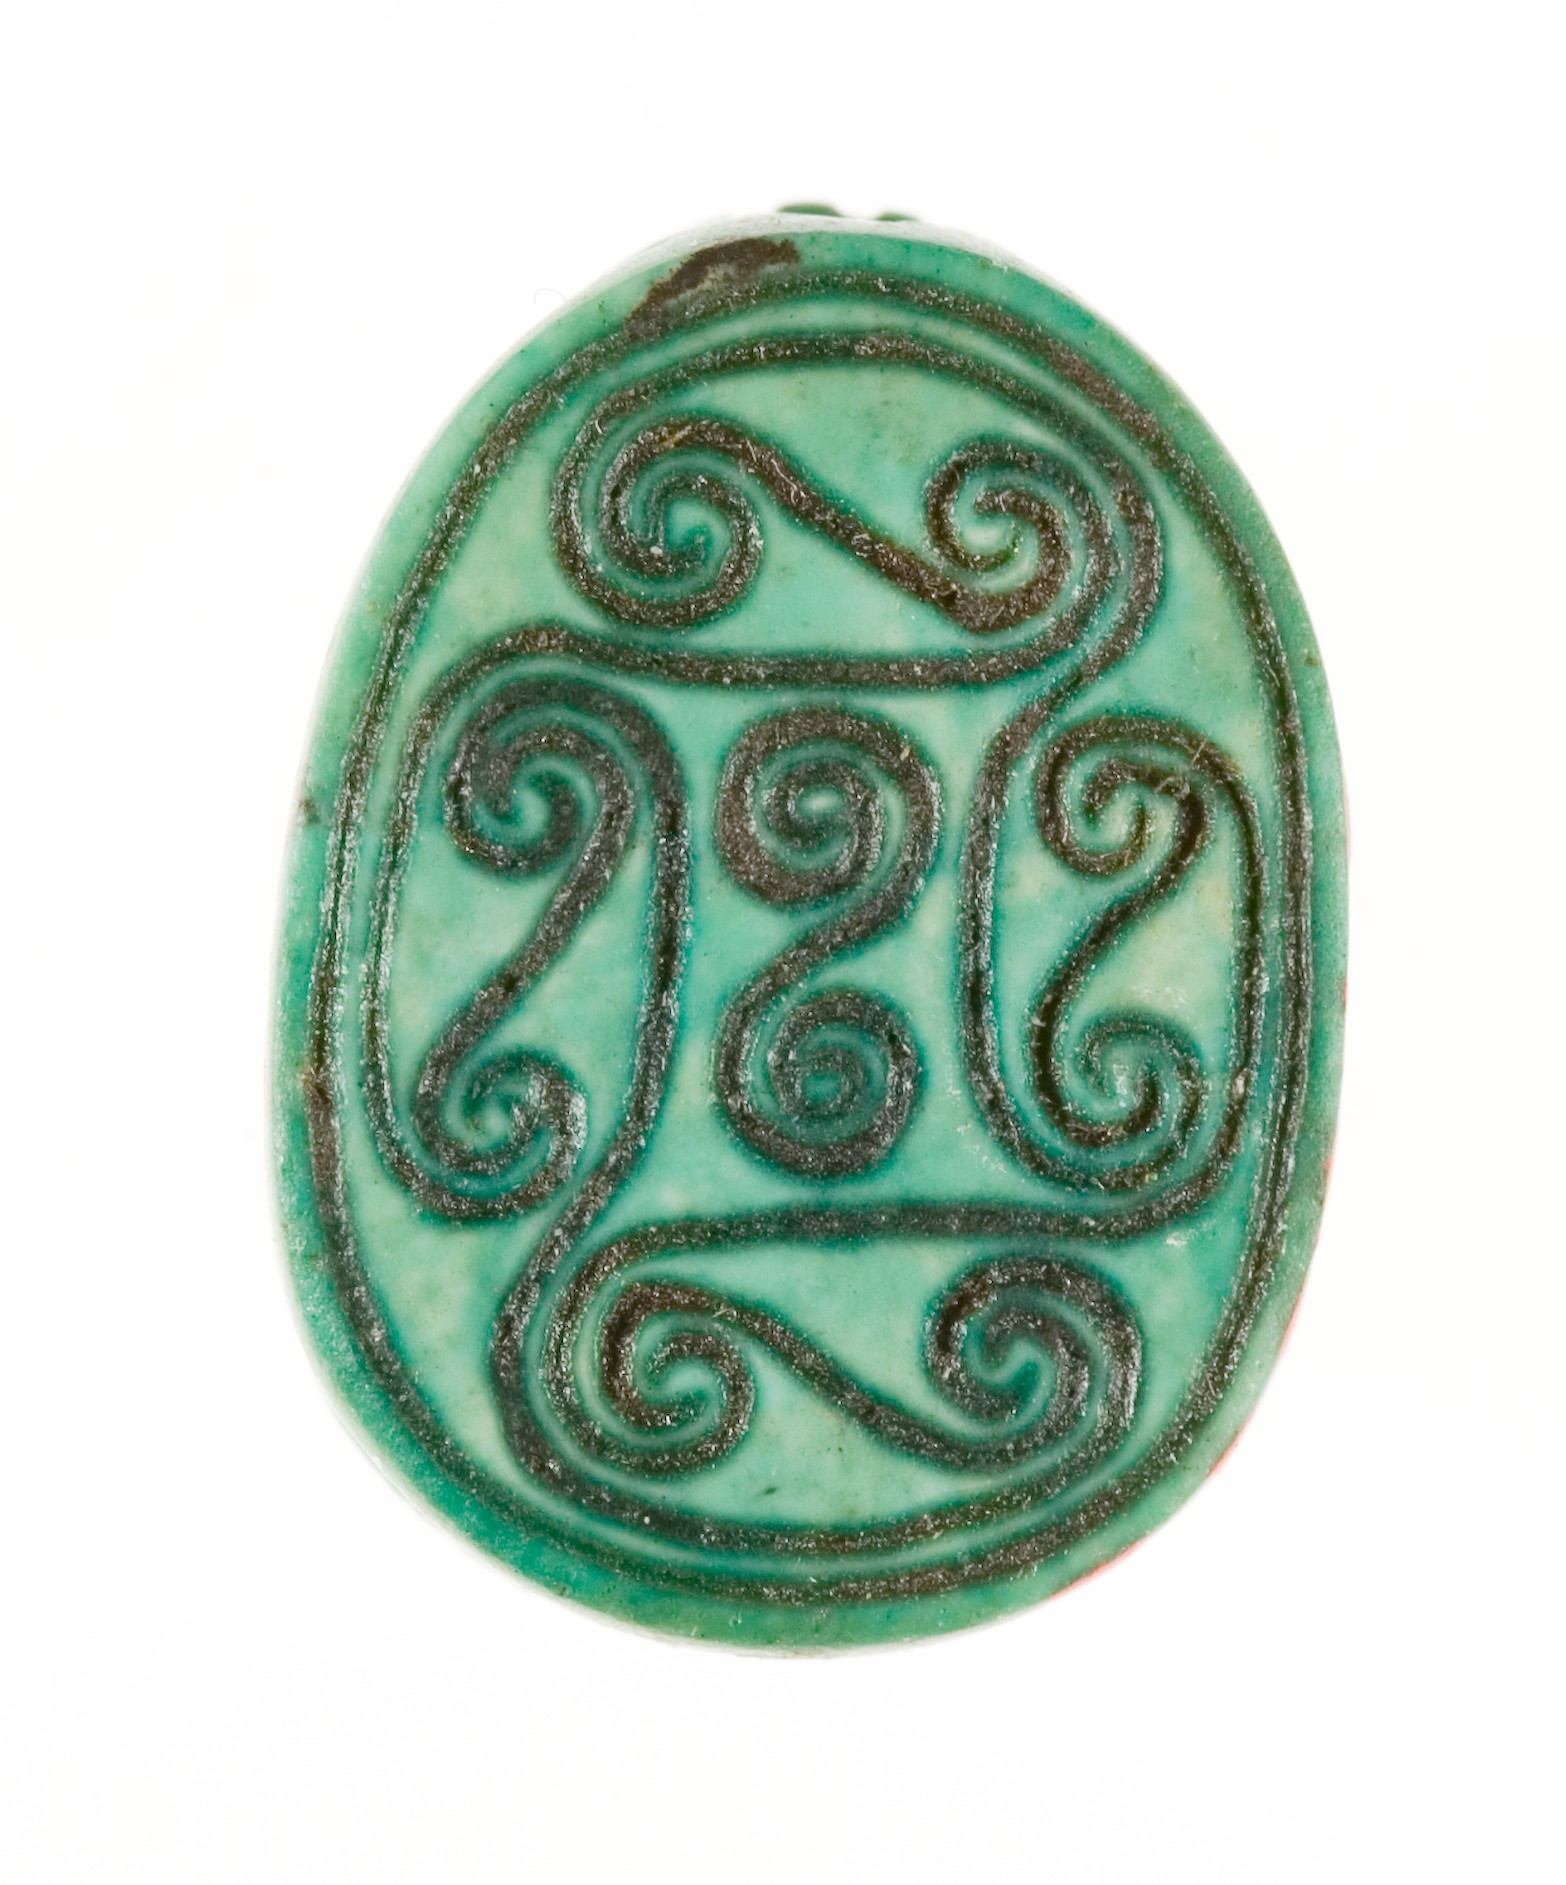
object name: scarab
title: Scarab Inscribed with a Geometric Pattern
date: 1479-1458 BCE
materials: stone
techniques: glazing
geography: egypt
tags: scarabs